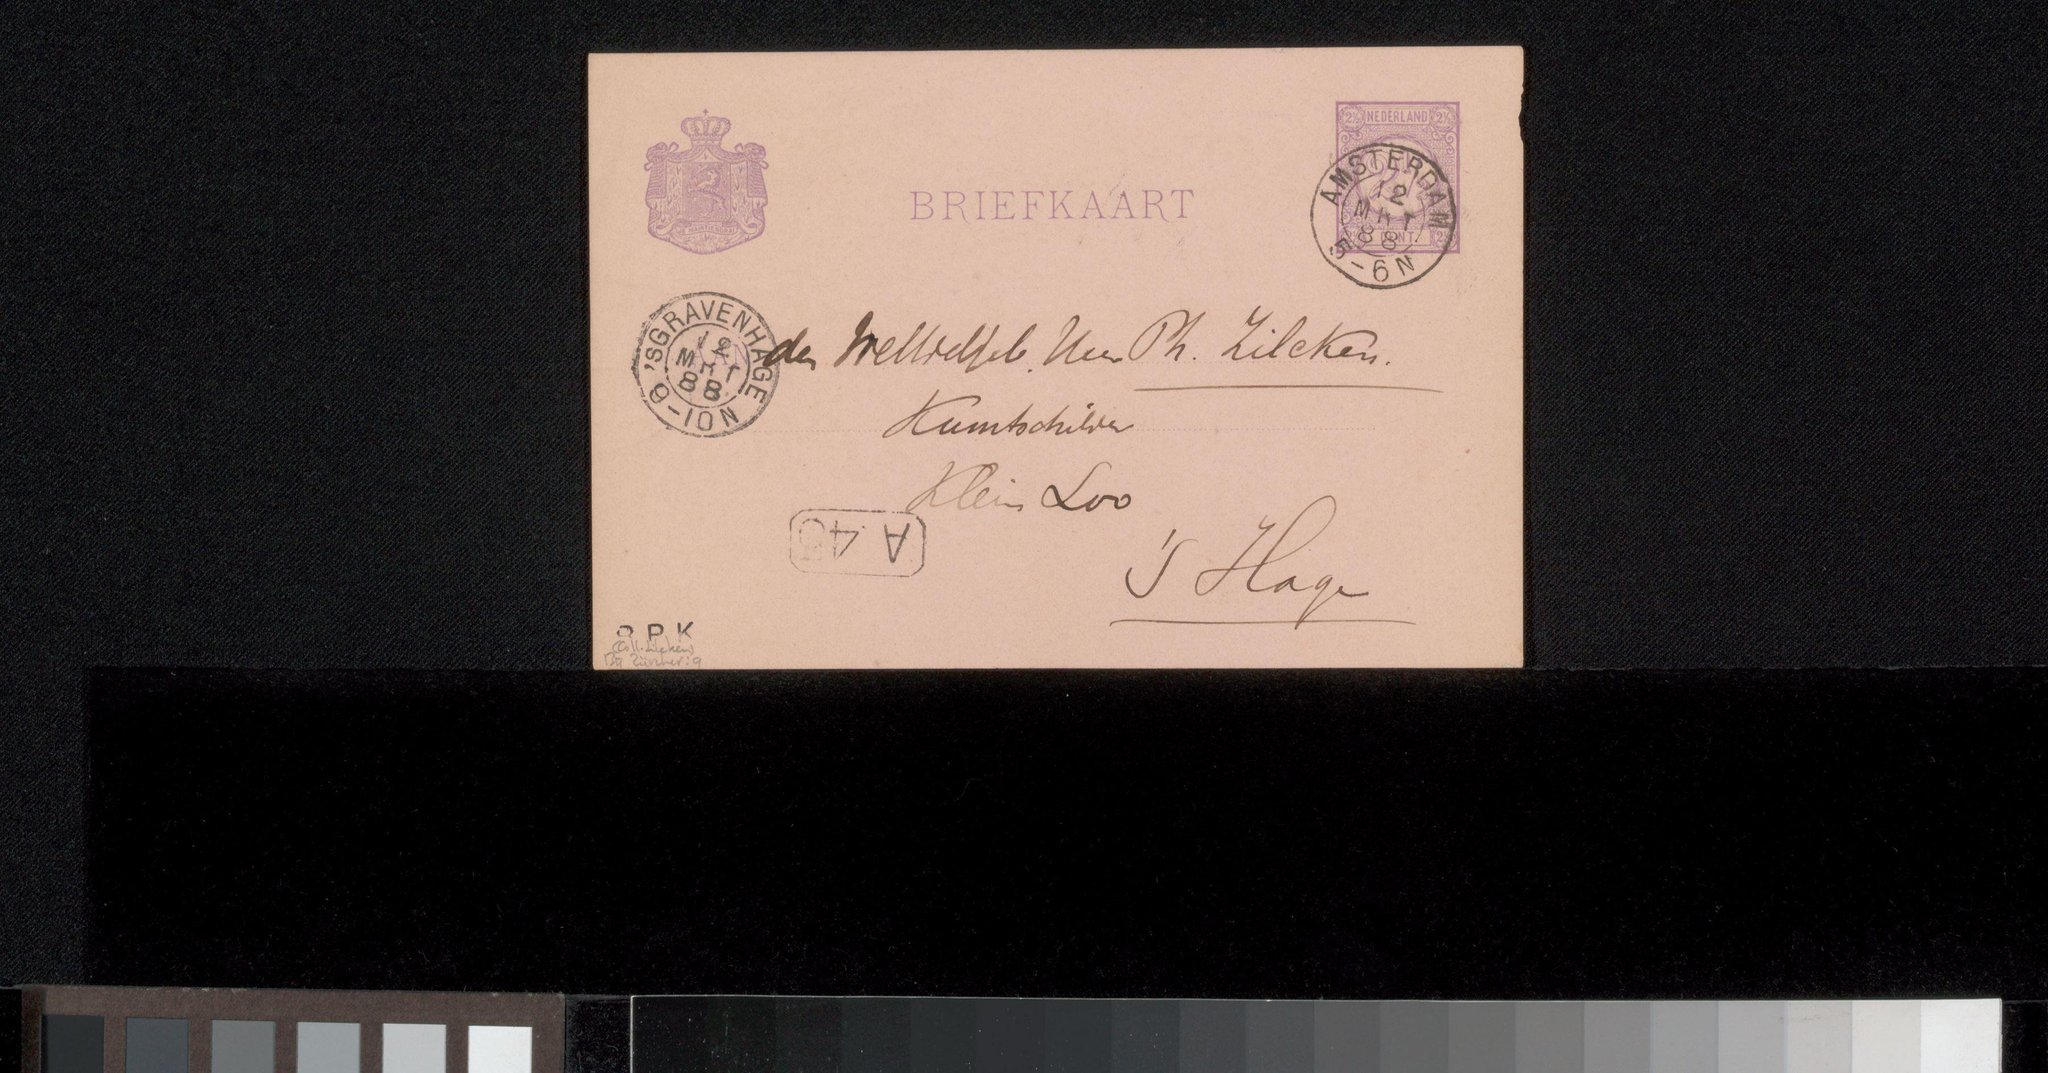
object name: postcard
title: Briefkaart aan Philip Zilcken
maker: jan zürcher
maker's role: painter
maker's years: 1851-1905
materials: cardboard, ink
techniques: pen, writing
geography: amsterdam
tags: draughtsman, philip zilcken, family life, diseases, the hague, rotterdam, amsterdam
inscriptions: collector's mark: ‘RPK’